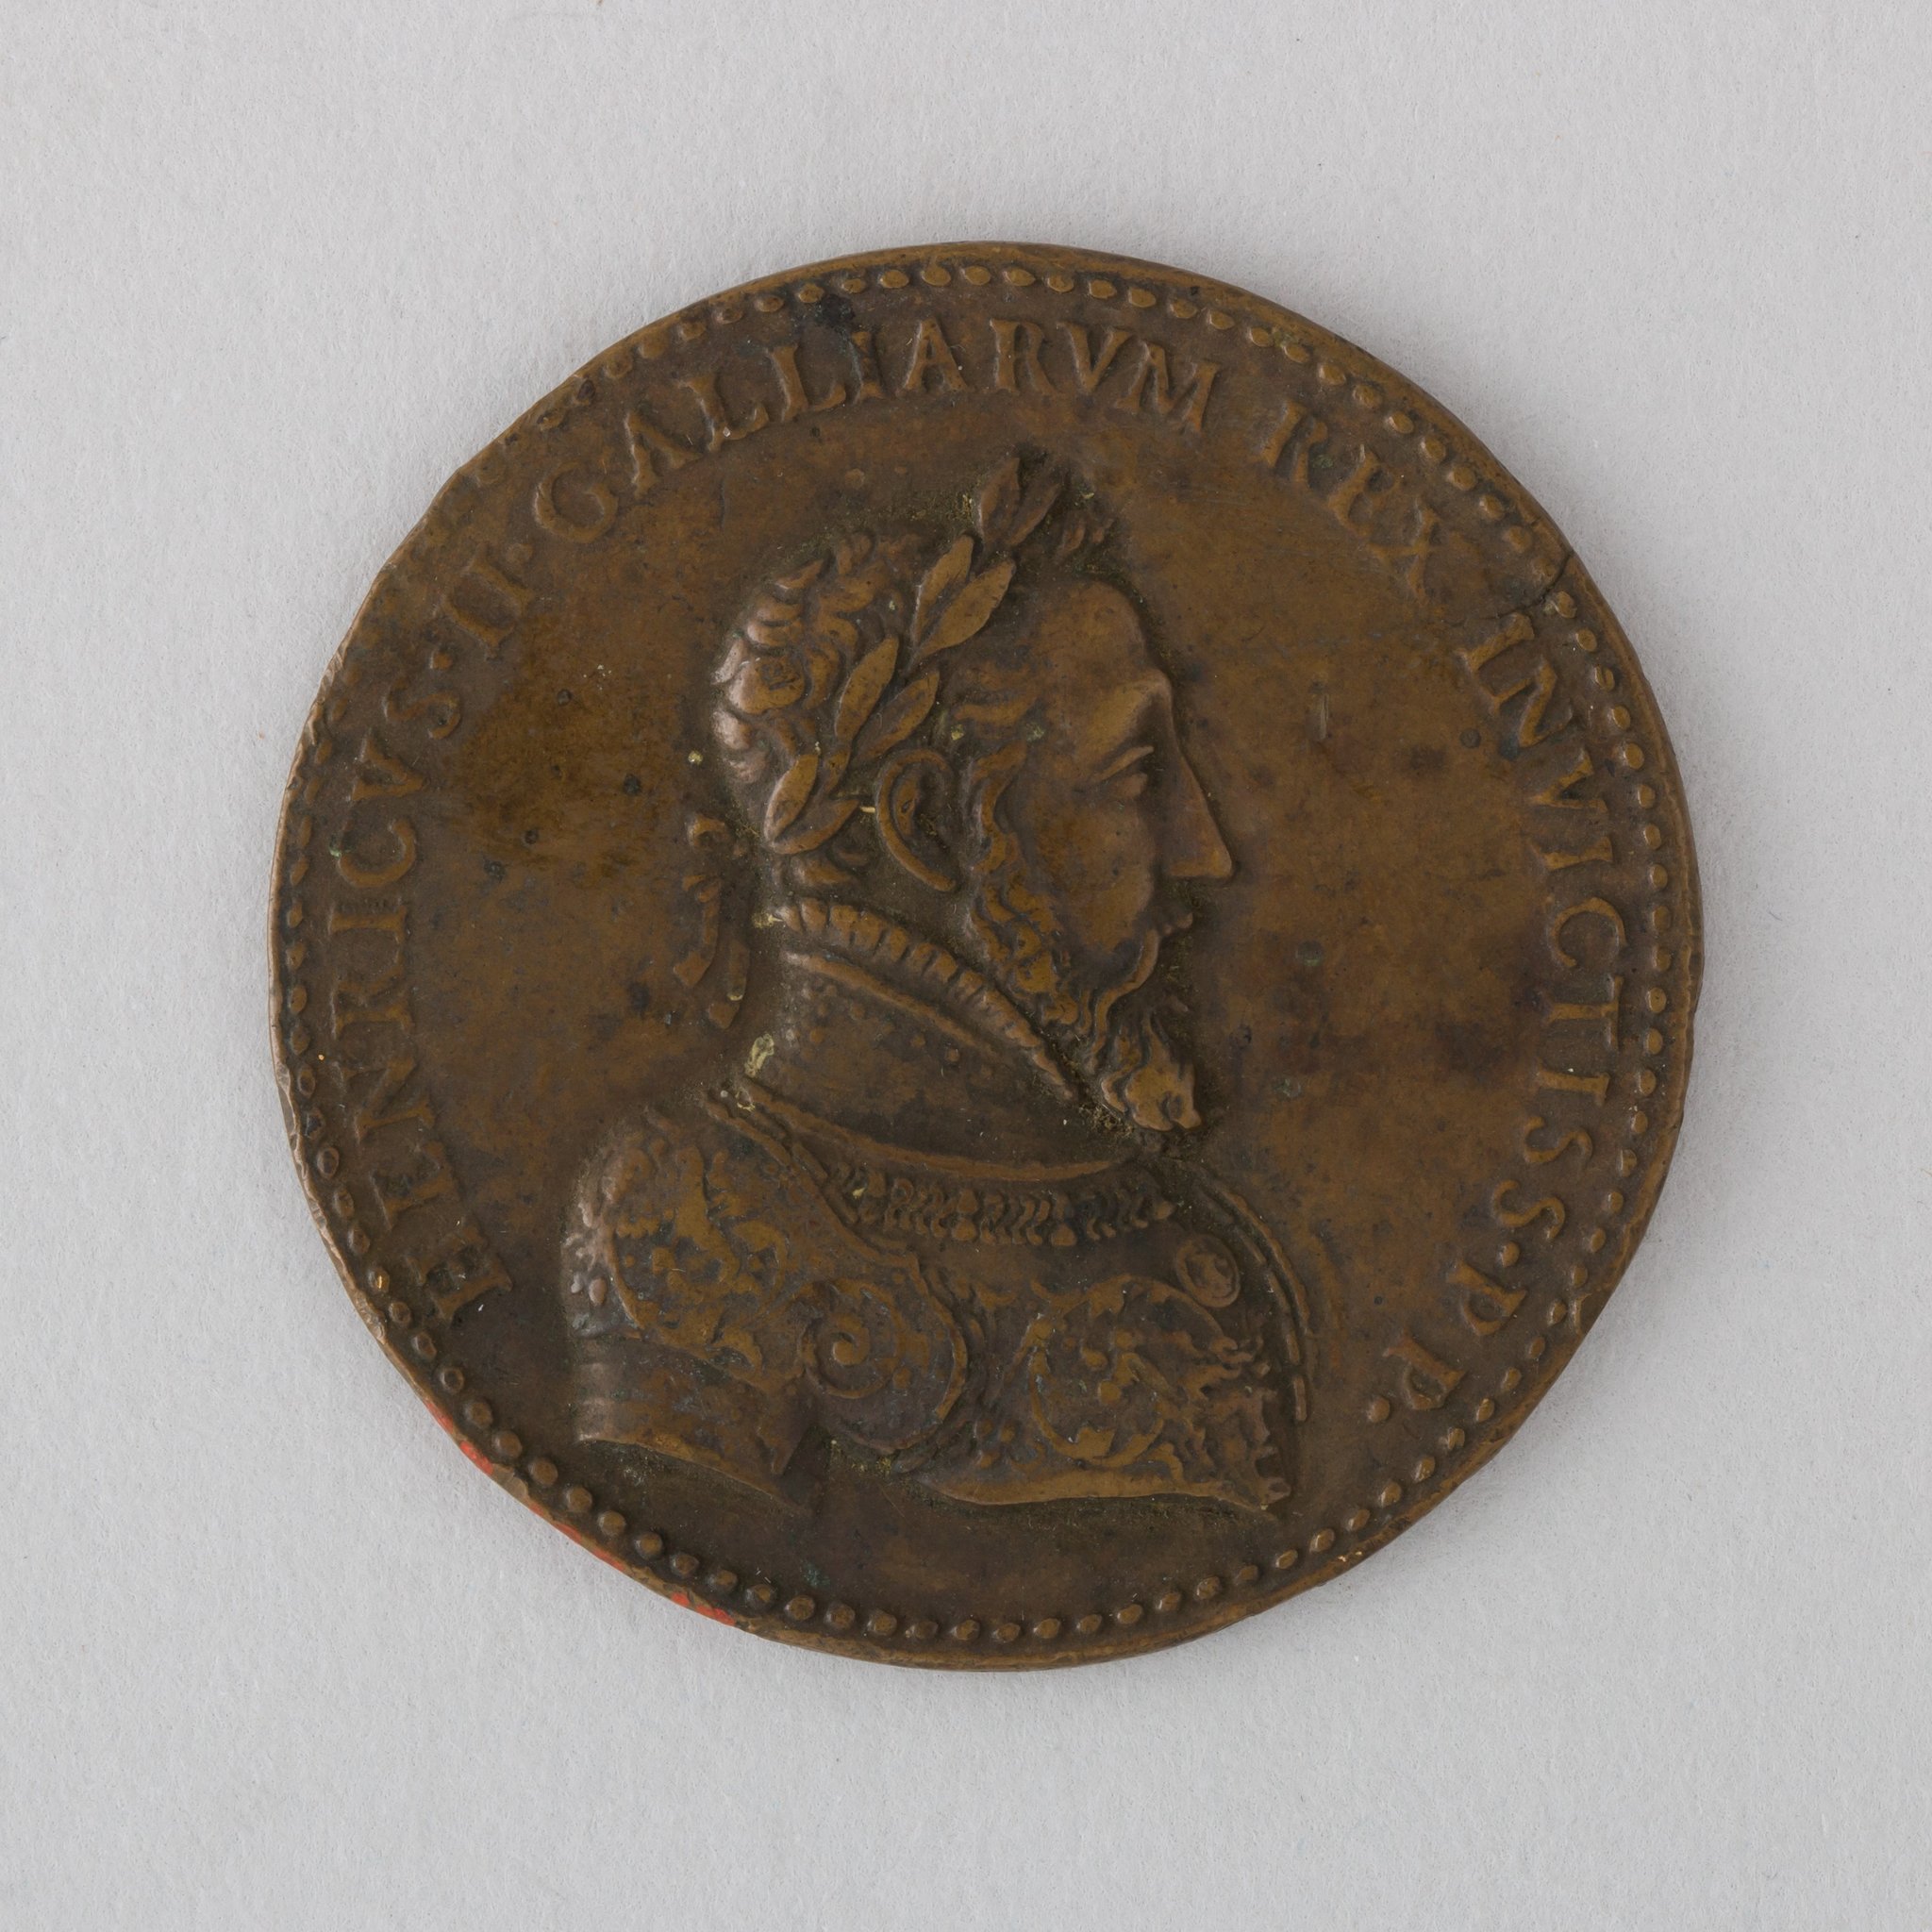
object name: medal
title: Medal Showing Henry II of France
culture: french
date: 1552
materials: bronze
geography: france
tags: men,profiles